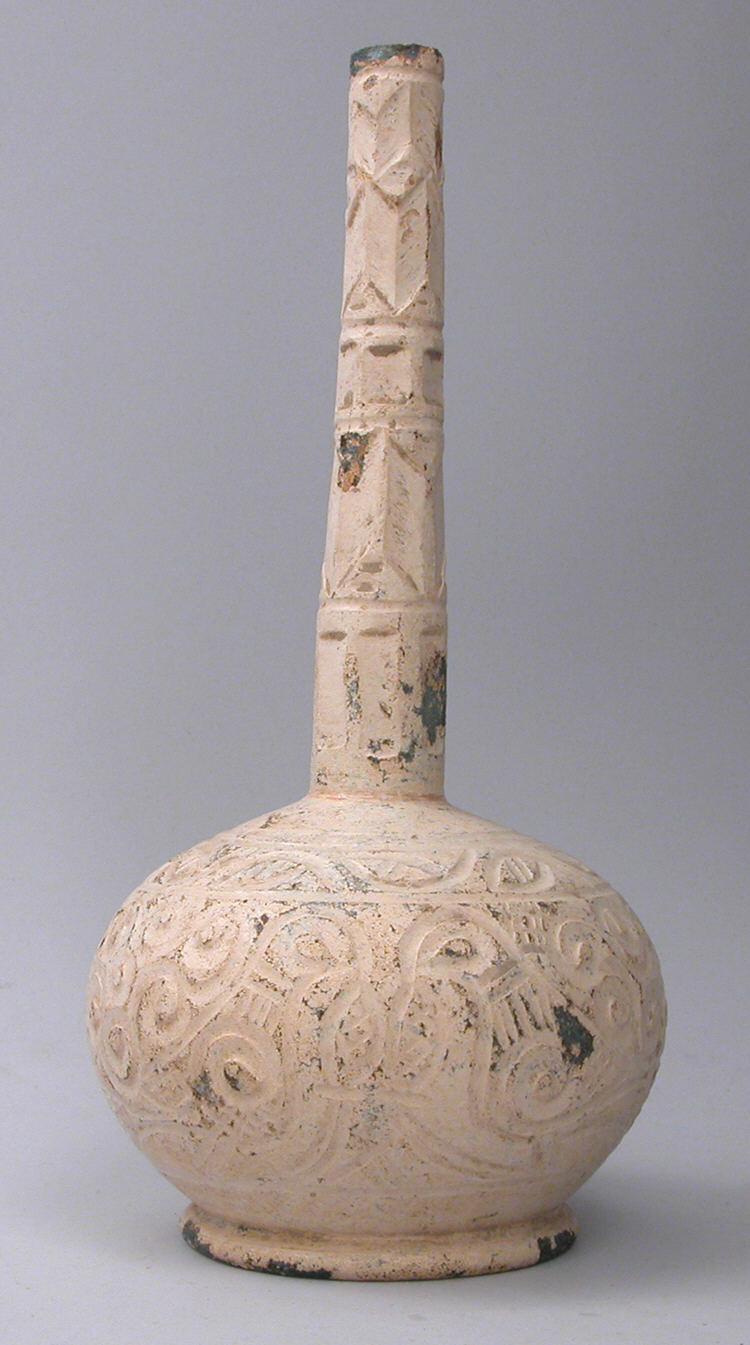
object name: bottle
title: Glass Bottle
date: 901-1100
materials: glass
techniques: cutting, glassblowing, tooling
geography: iran